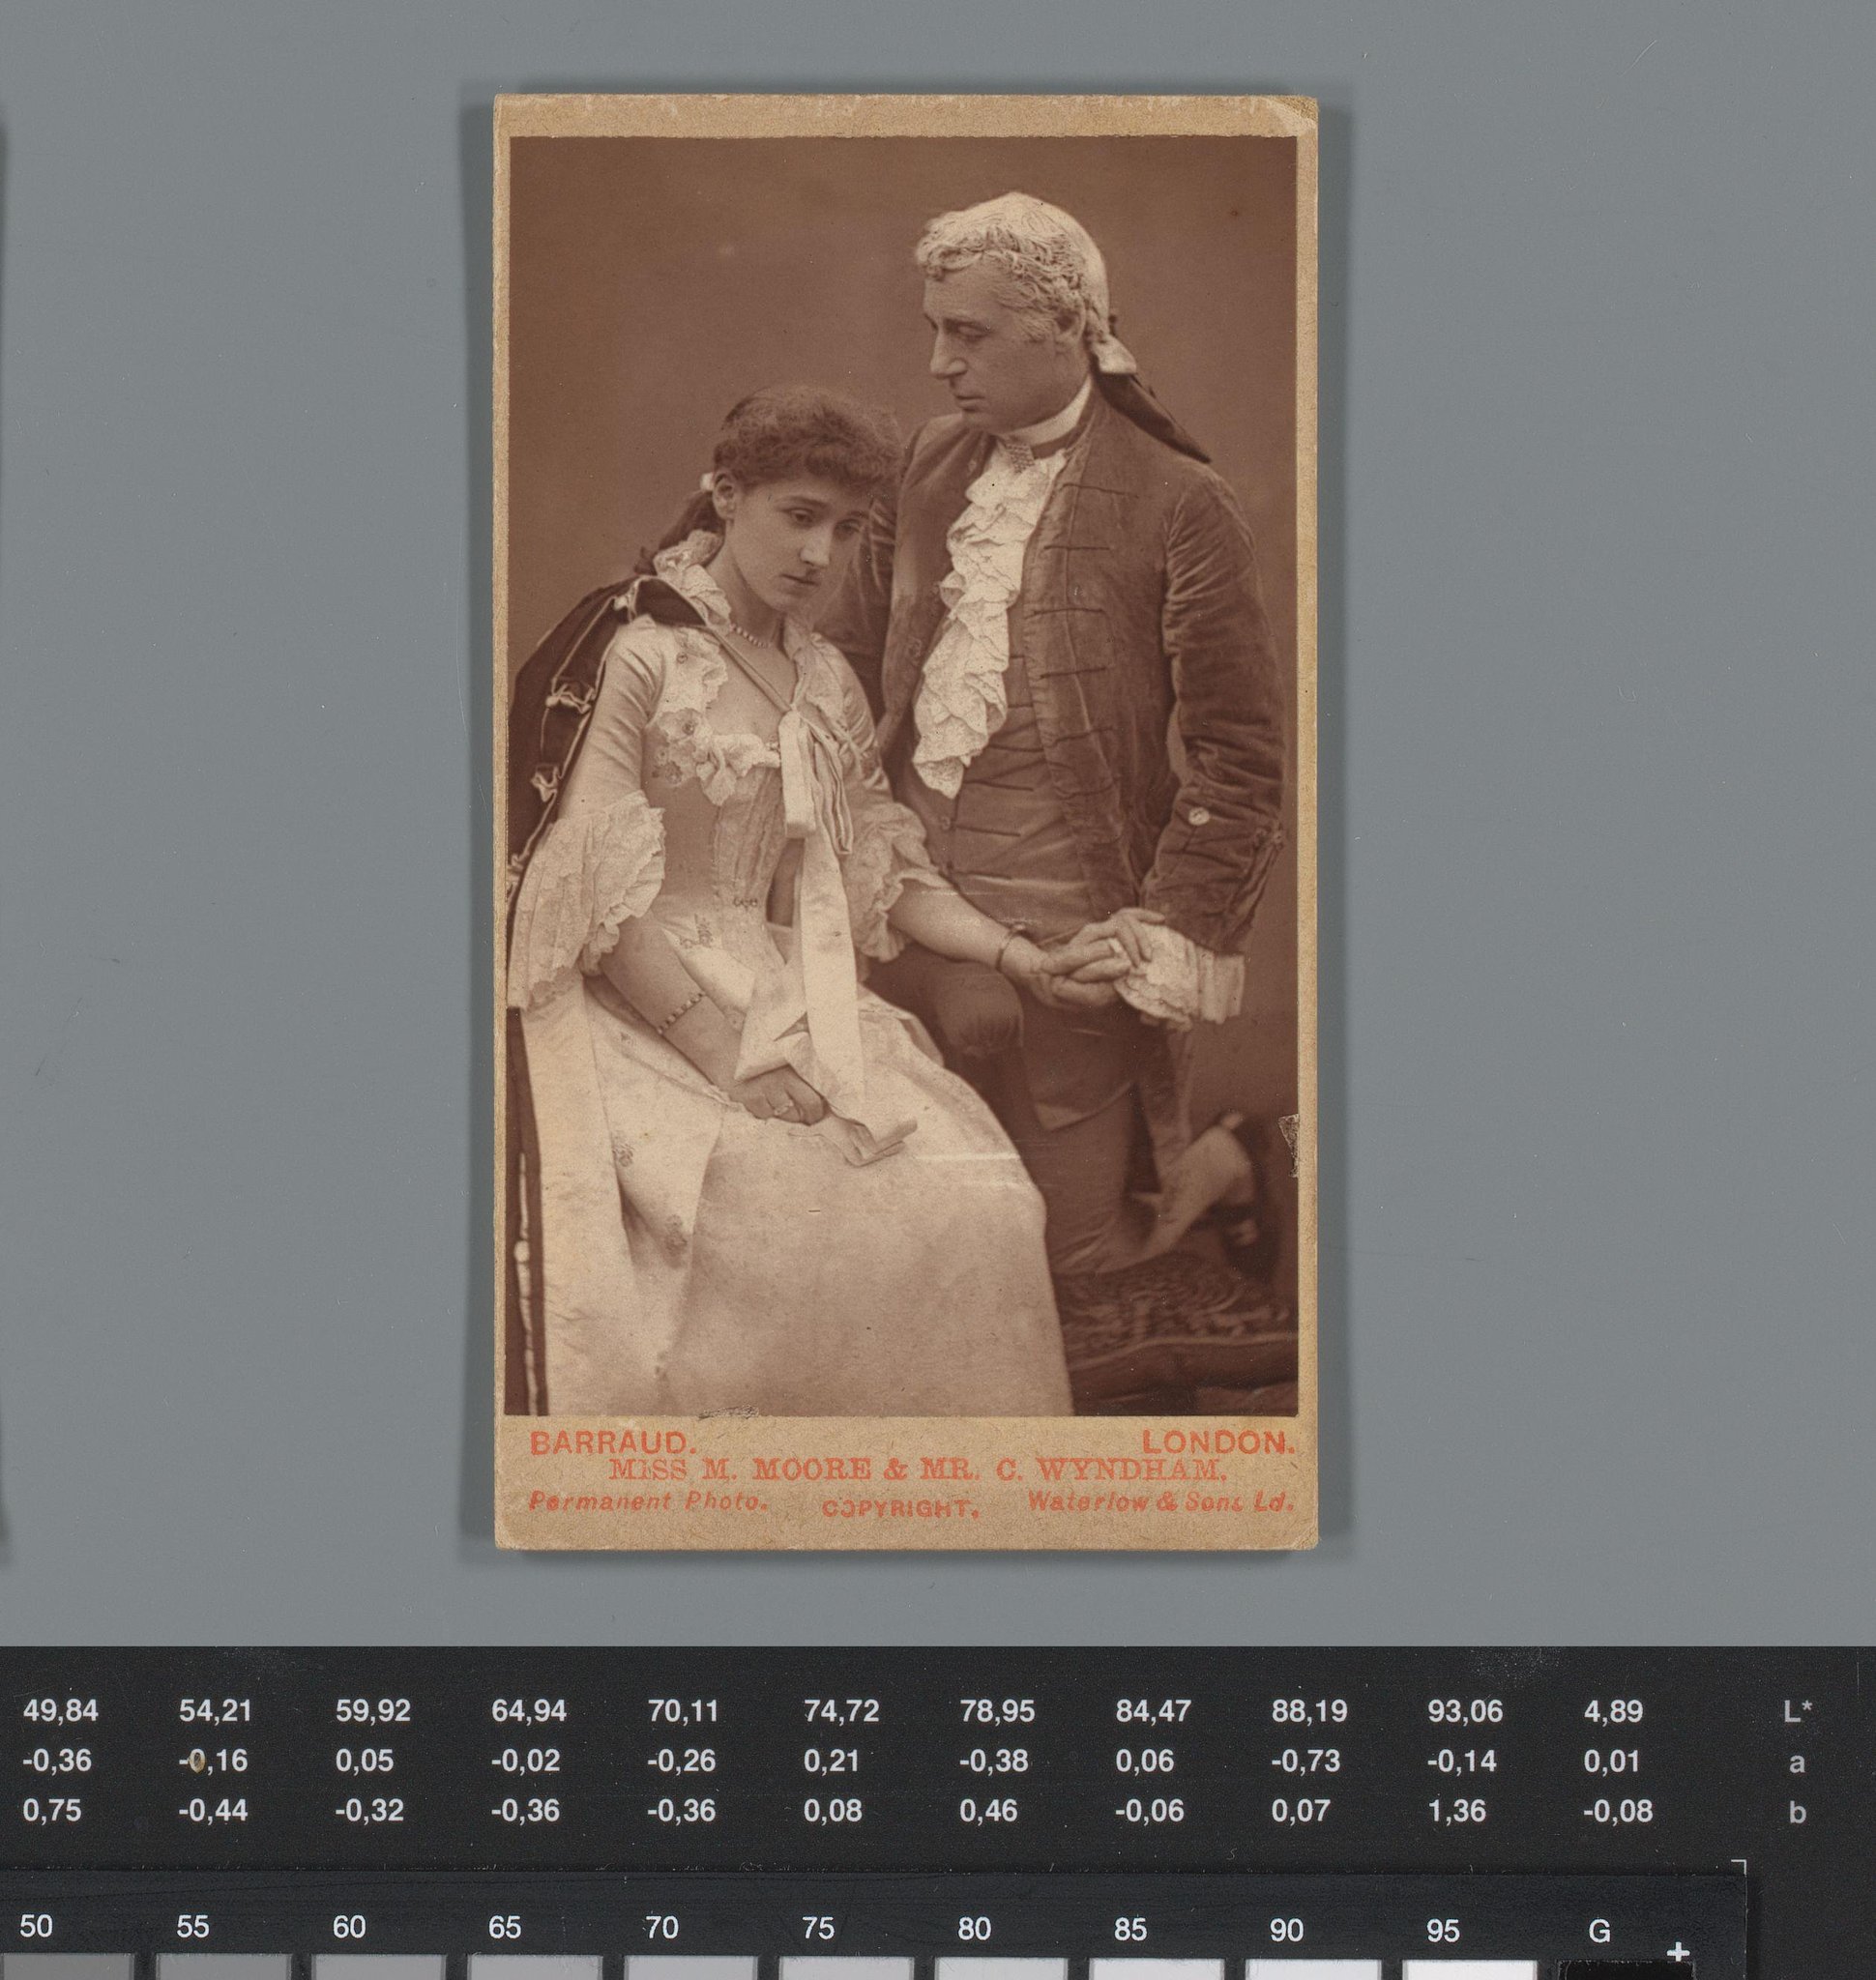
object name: carte de visite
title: Reclame voor Taunus mineraalwater met een portret van Mary Moore en Charles Wyndham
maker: herbert rose barraud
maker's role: fotograaf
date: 1865-1900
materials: cardboard, photographic support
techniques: woodburytype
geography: london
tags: liverpool, london, advertising, historical persons - bb - woman, historical persons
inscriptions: inscription: ‘TAUNUS / A PURE NATURAL / MINERAL WATER.’